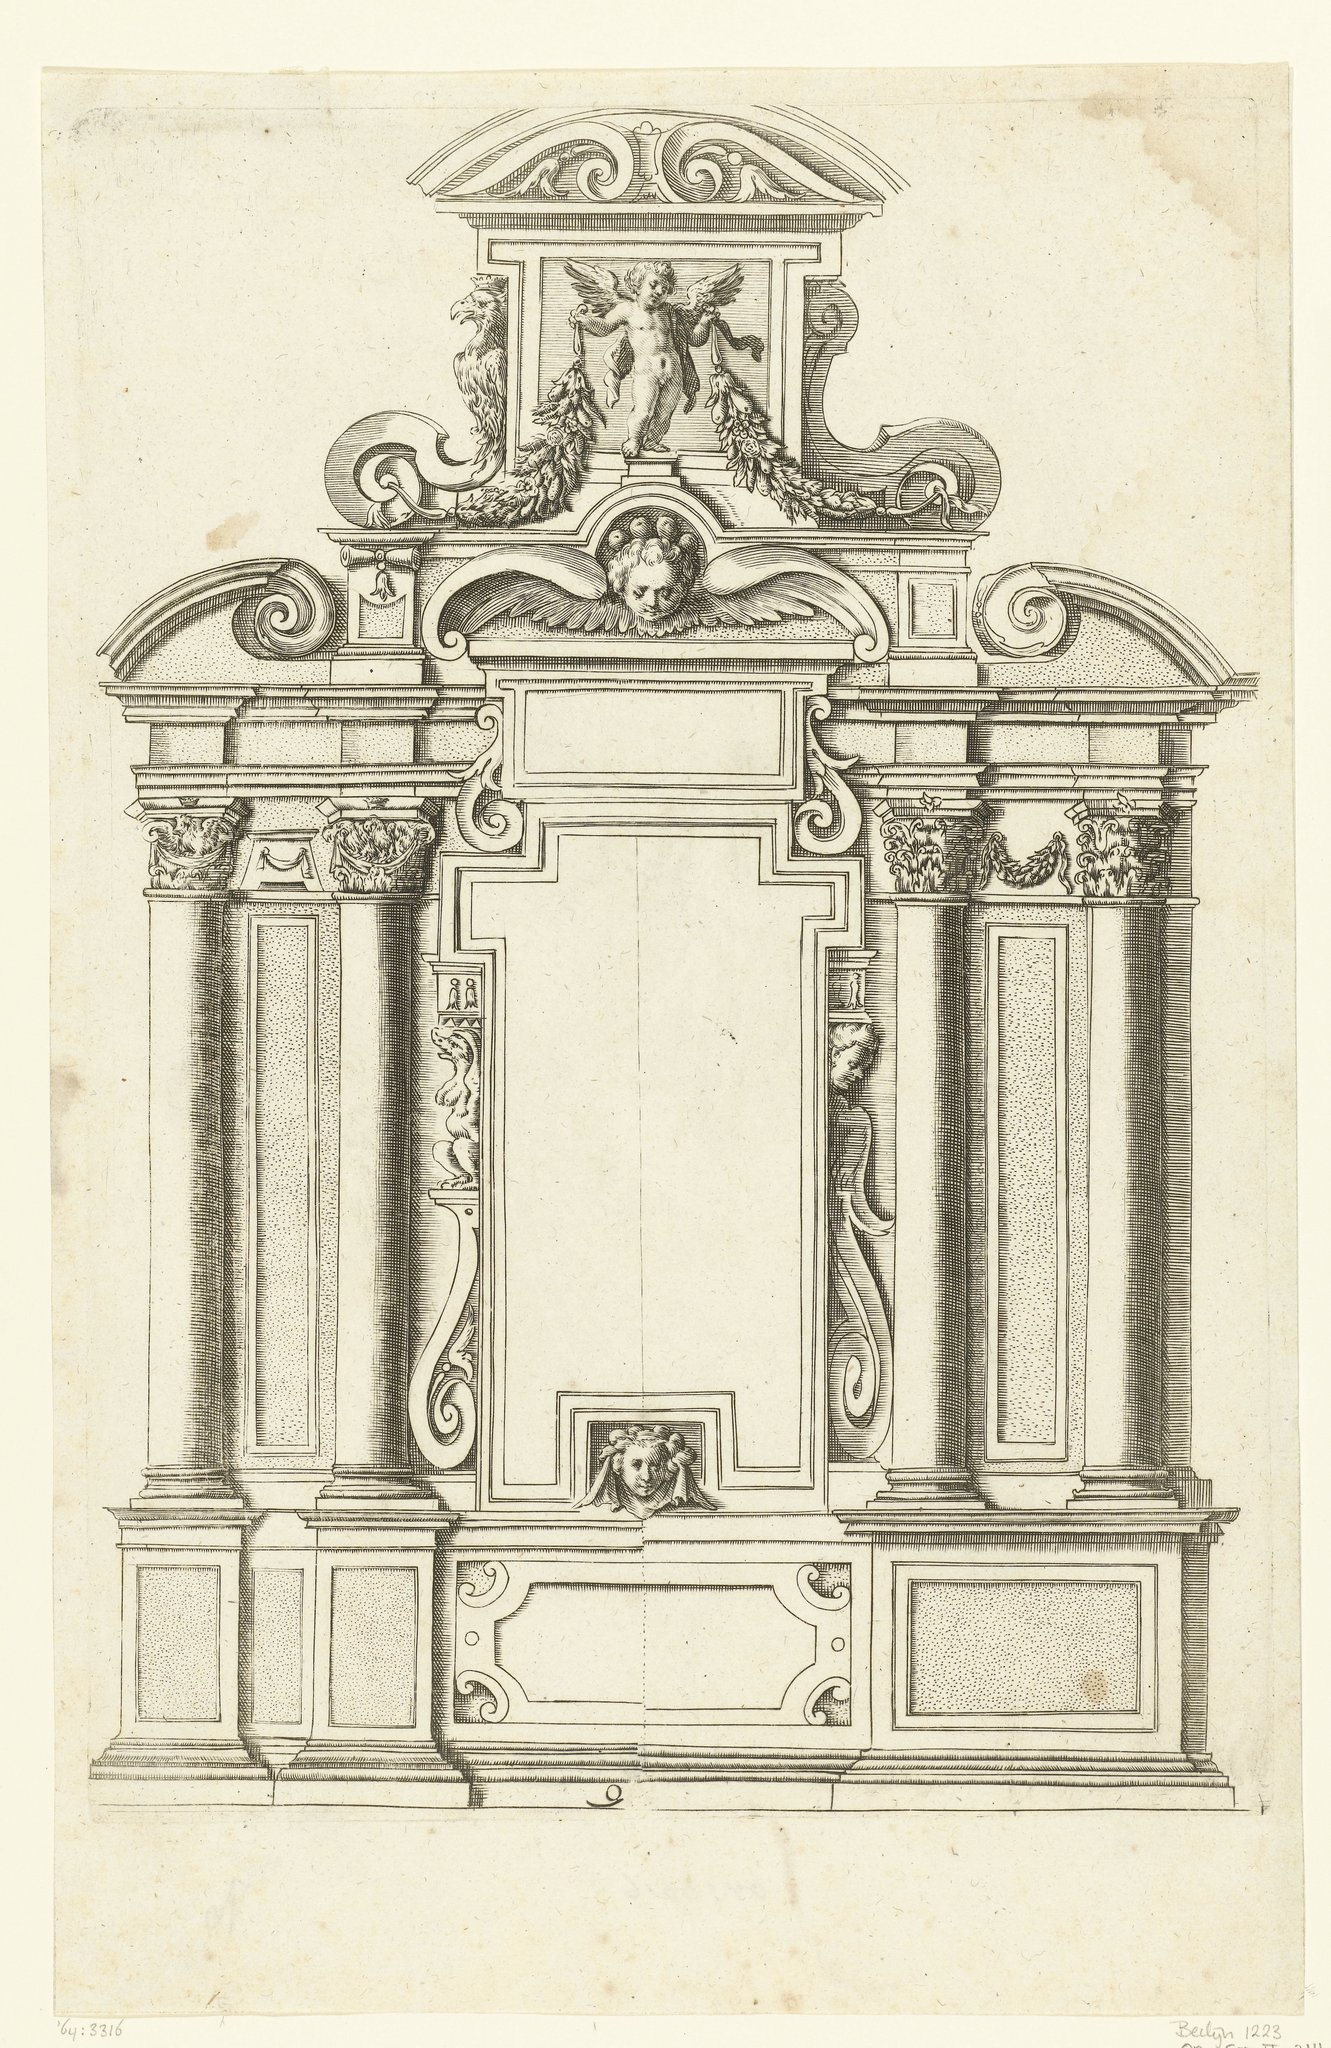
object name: ornament print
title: Oficina Arcvlaria ((...)), Bovticqve Menvseries ((...)), Schriner Laden ((...)), Schrinwerckers Winckel (...)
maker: Anonymous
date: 1642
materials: paper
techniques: engraving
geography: amsterdam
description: Met een variant voor de rechterhelft. Het paneel wordt geflankeerd door Korintische zuilen.